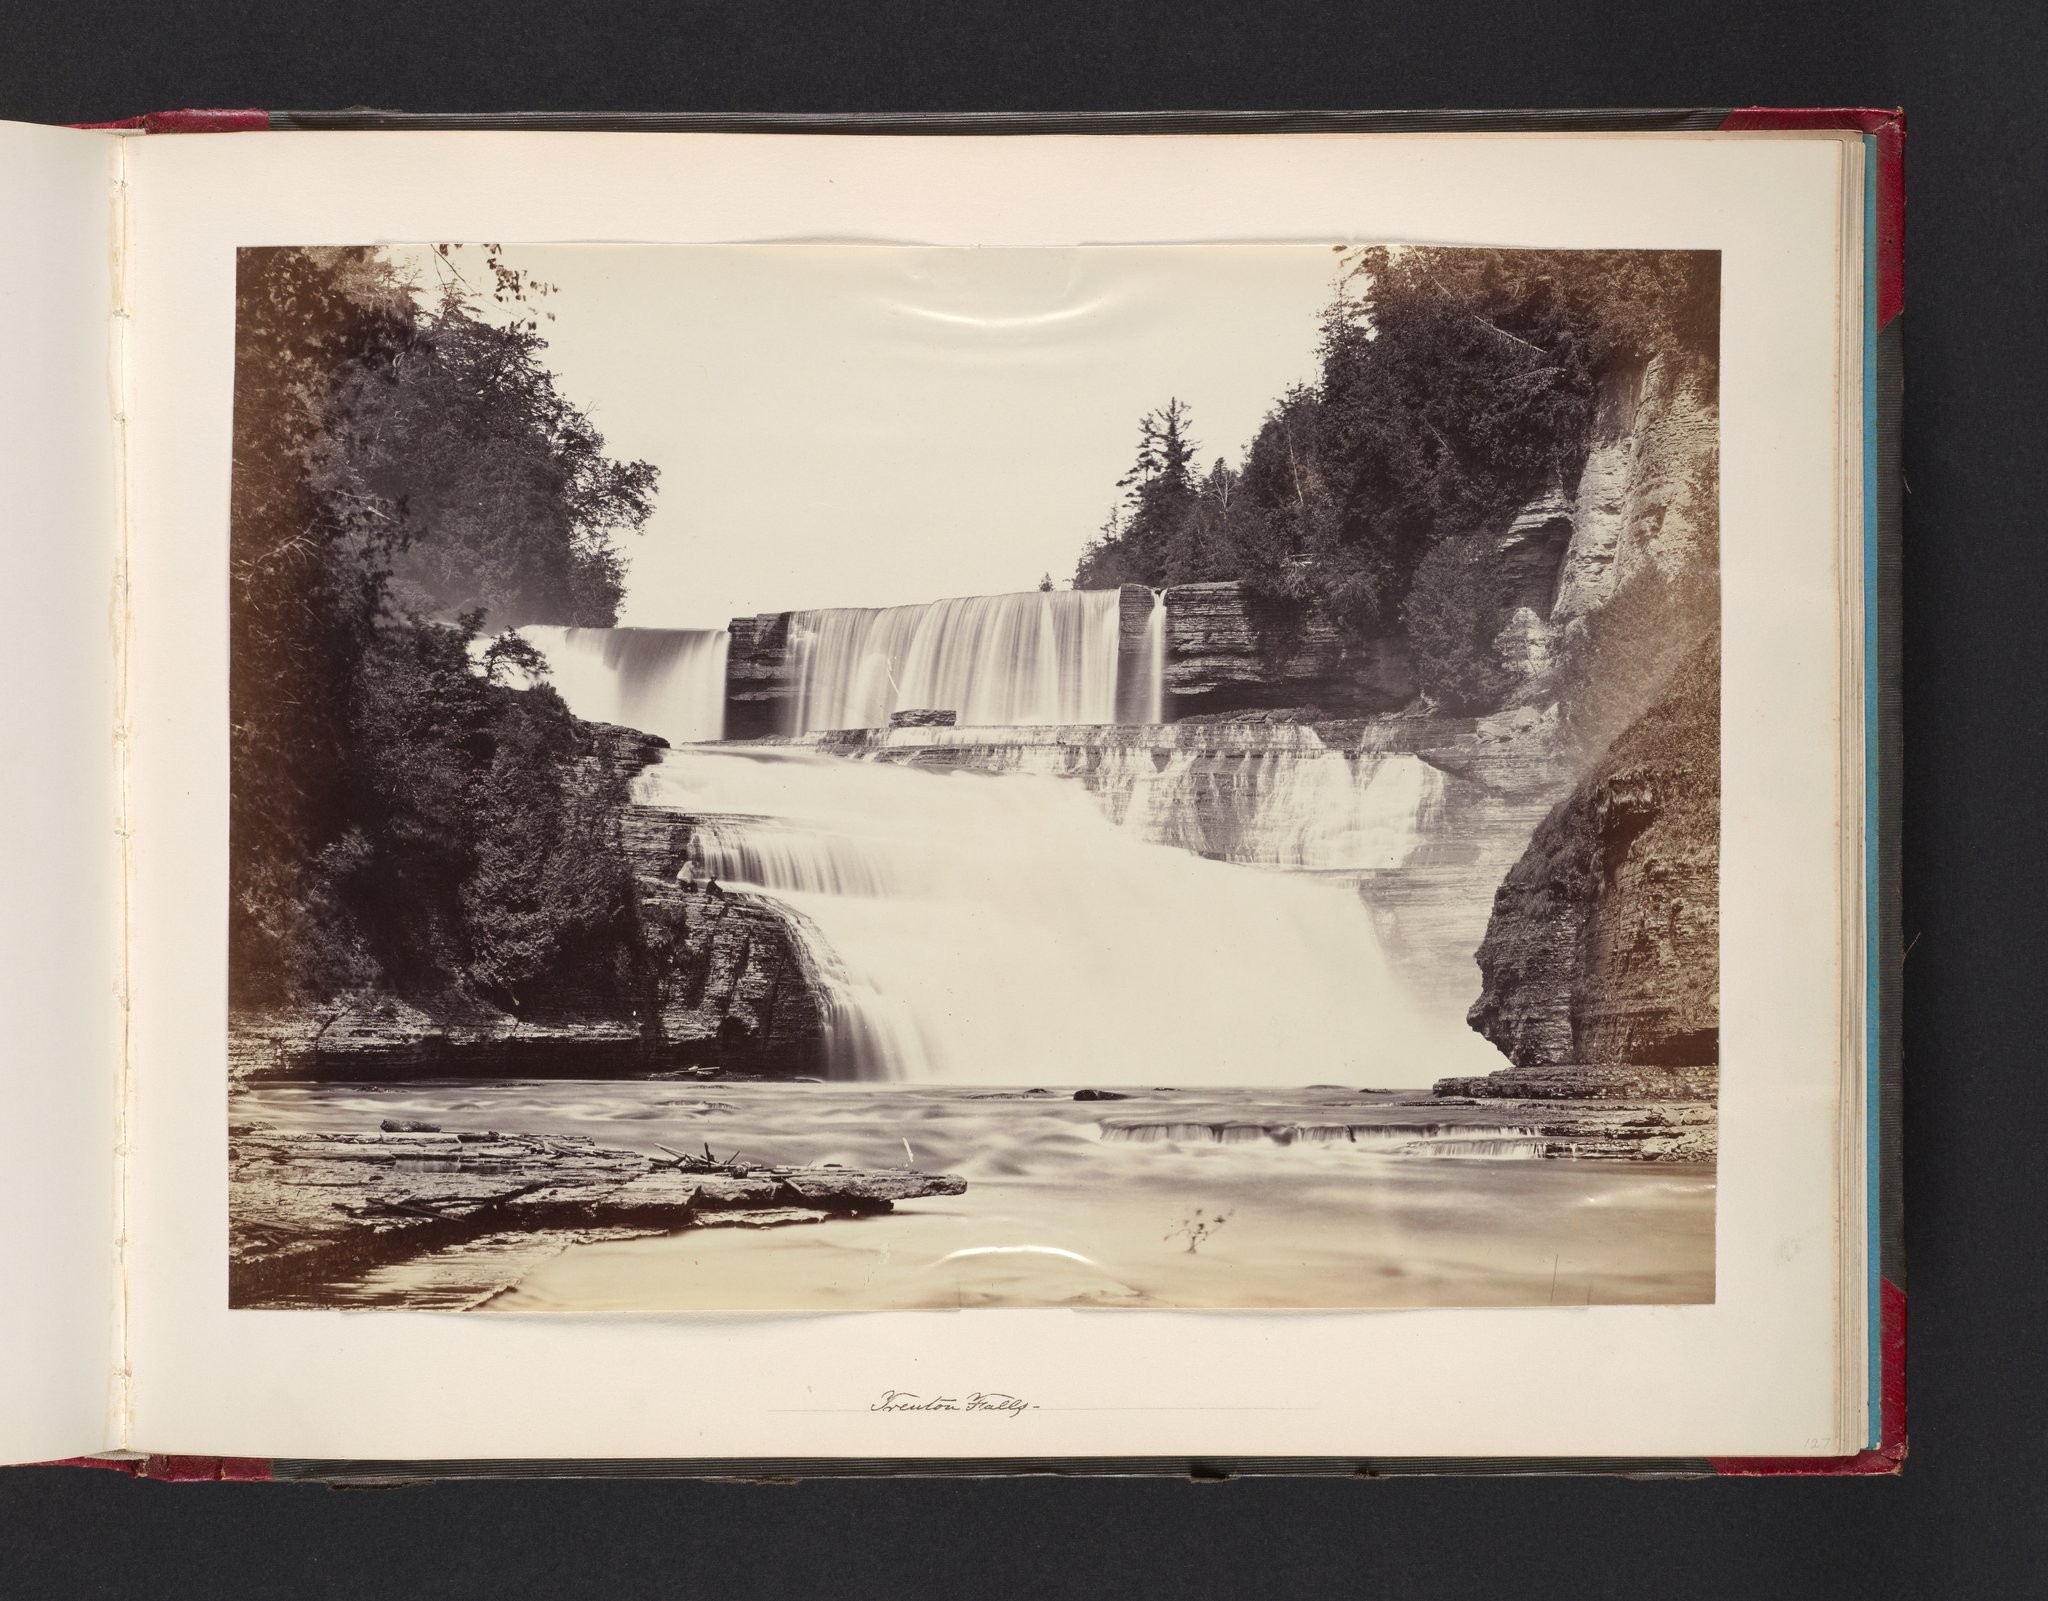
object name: photograph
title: Trenton Falls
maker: john thomson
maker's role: artist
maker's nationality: british, scottish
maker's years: 1837-1921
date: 1865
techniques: albumen silver print, glass negative